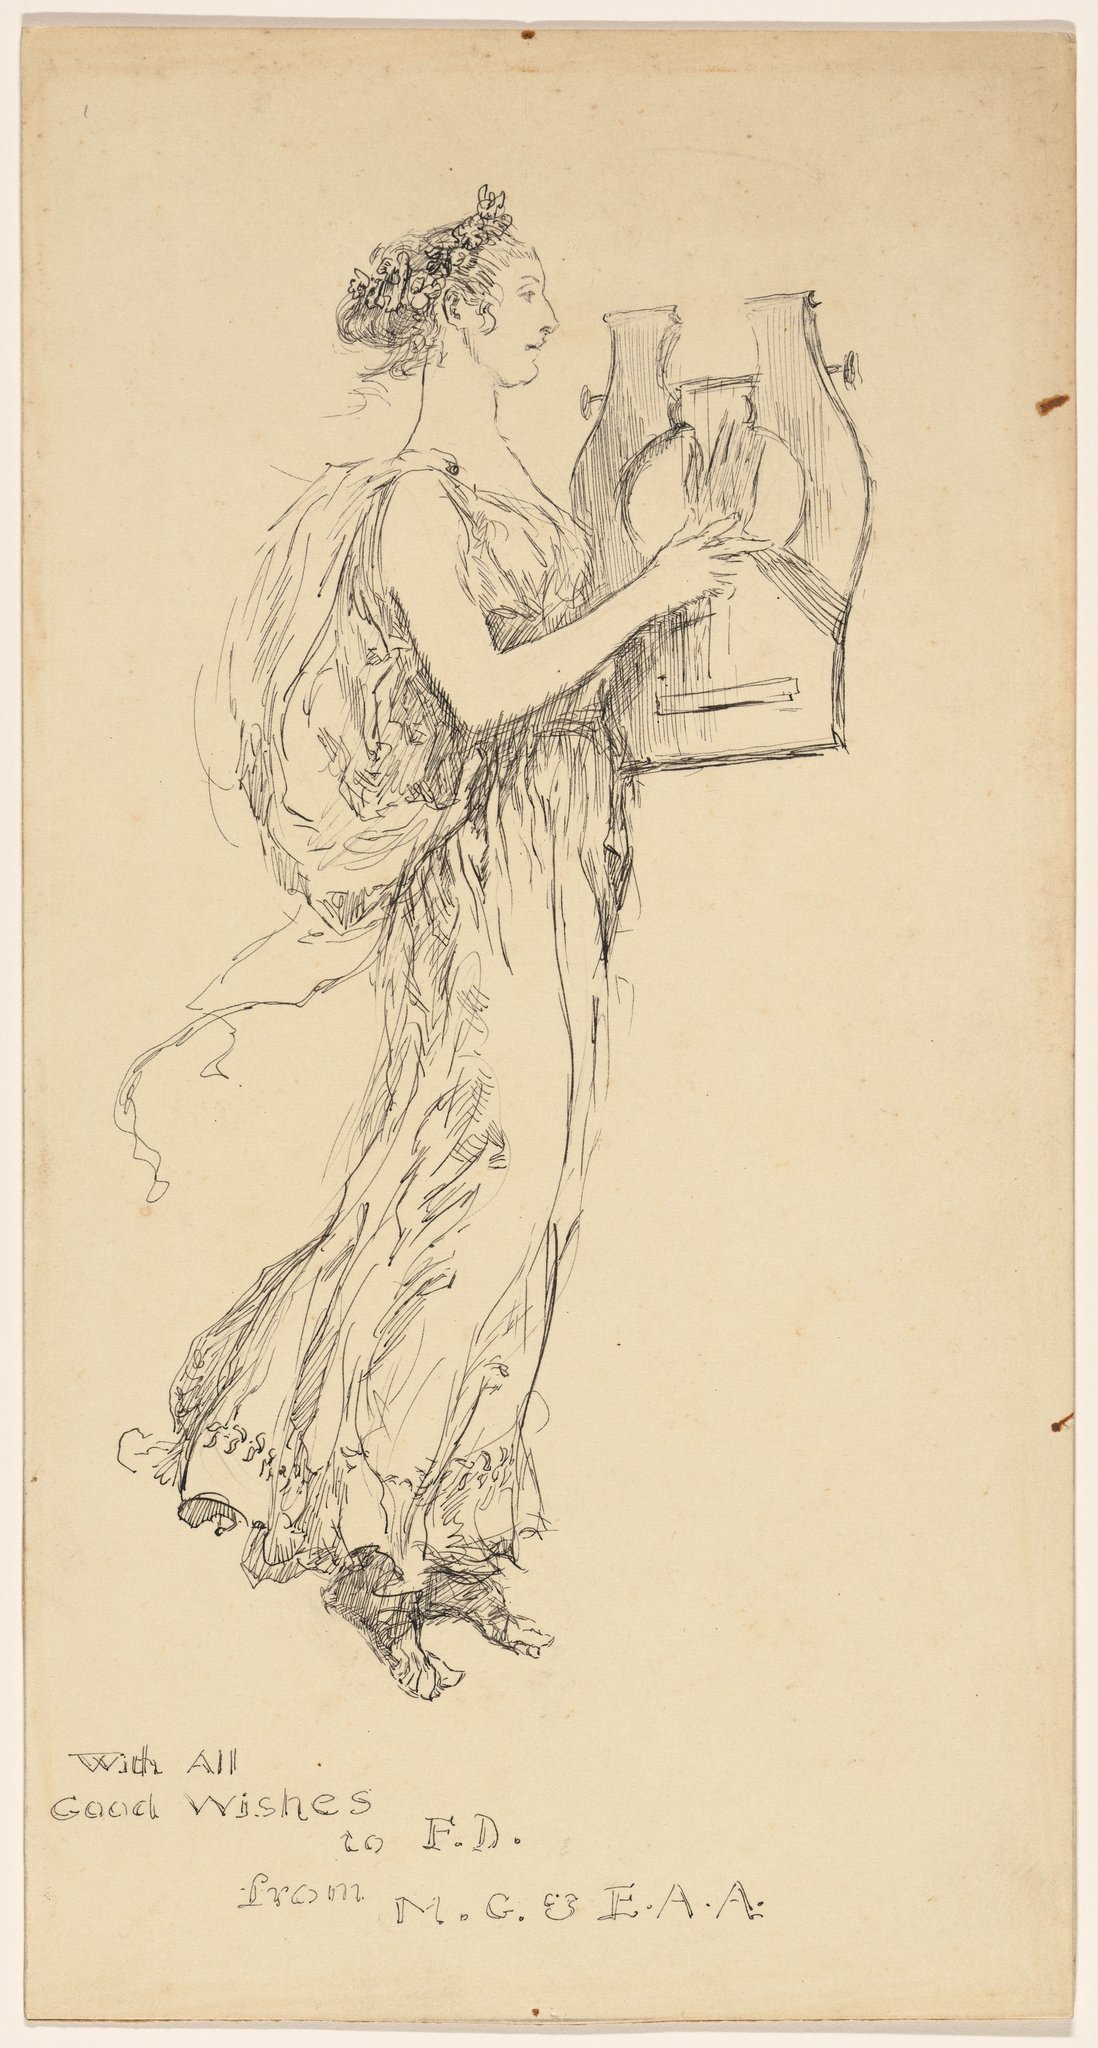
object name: drawing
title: Woman in a Grecian Gown Playing a Lyre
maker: edwin austin abbey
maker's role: artist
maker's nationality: american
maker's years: 1852-1911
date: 1890-1911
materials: ink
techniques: pen